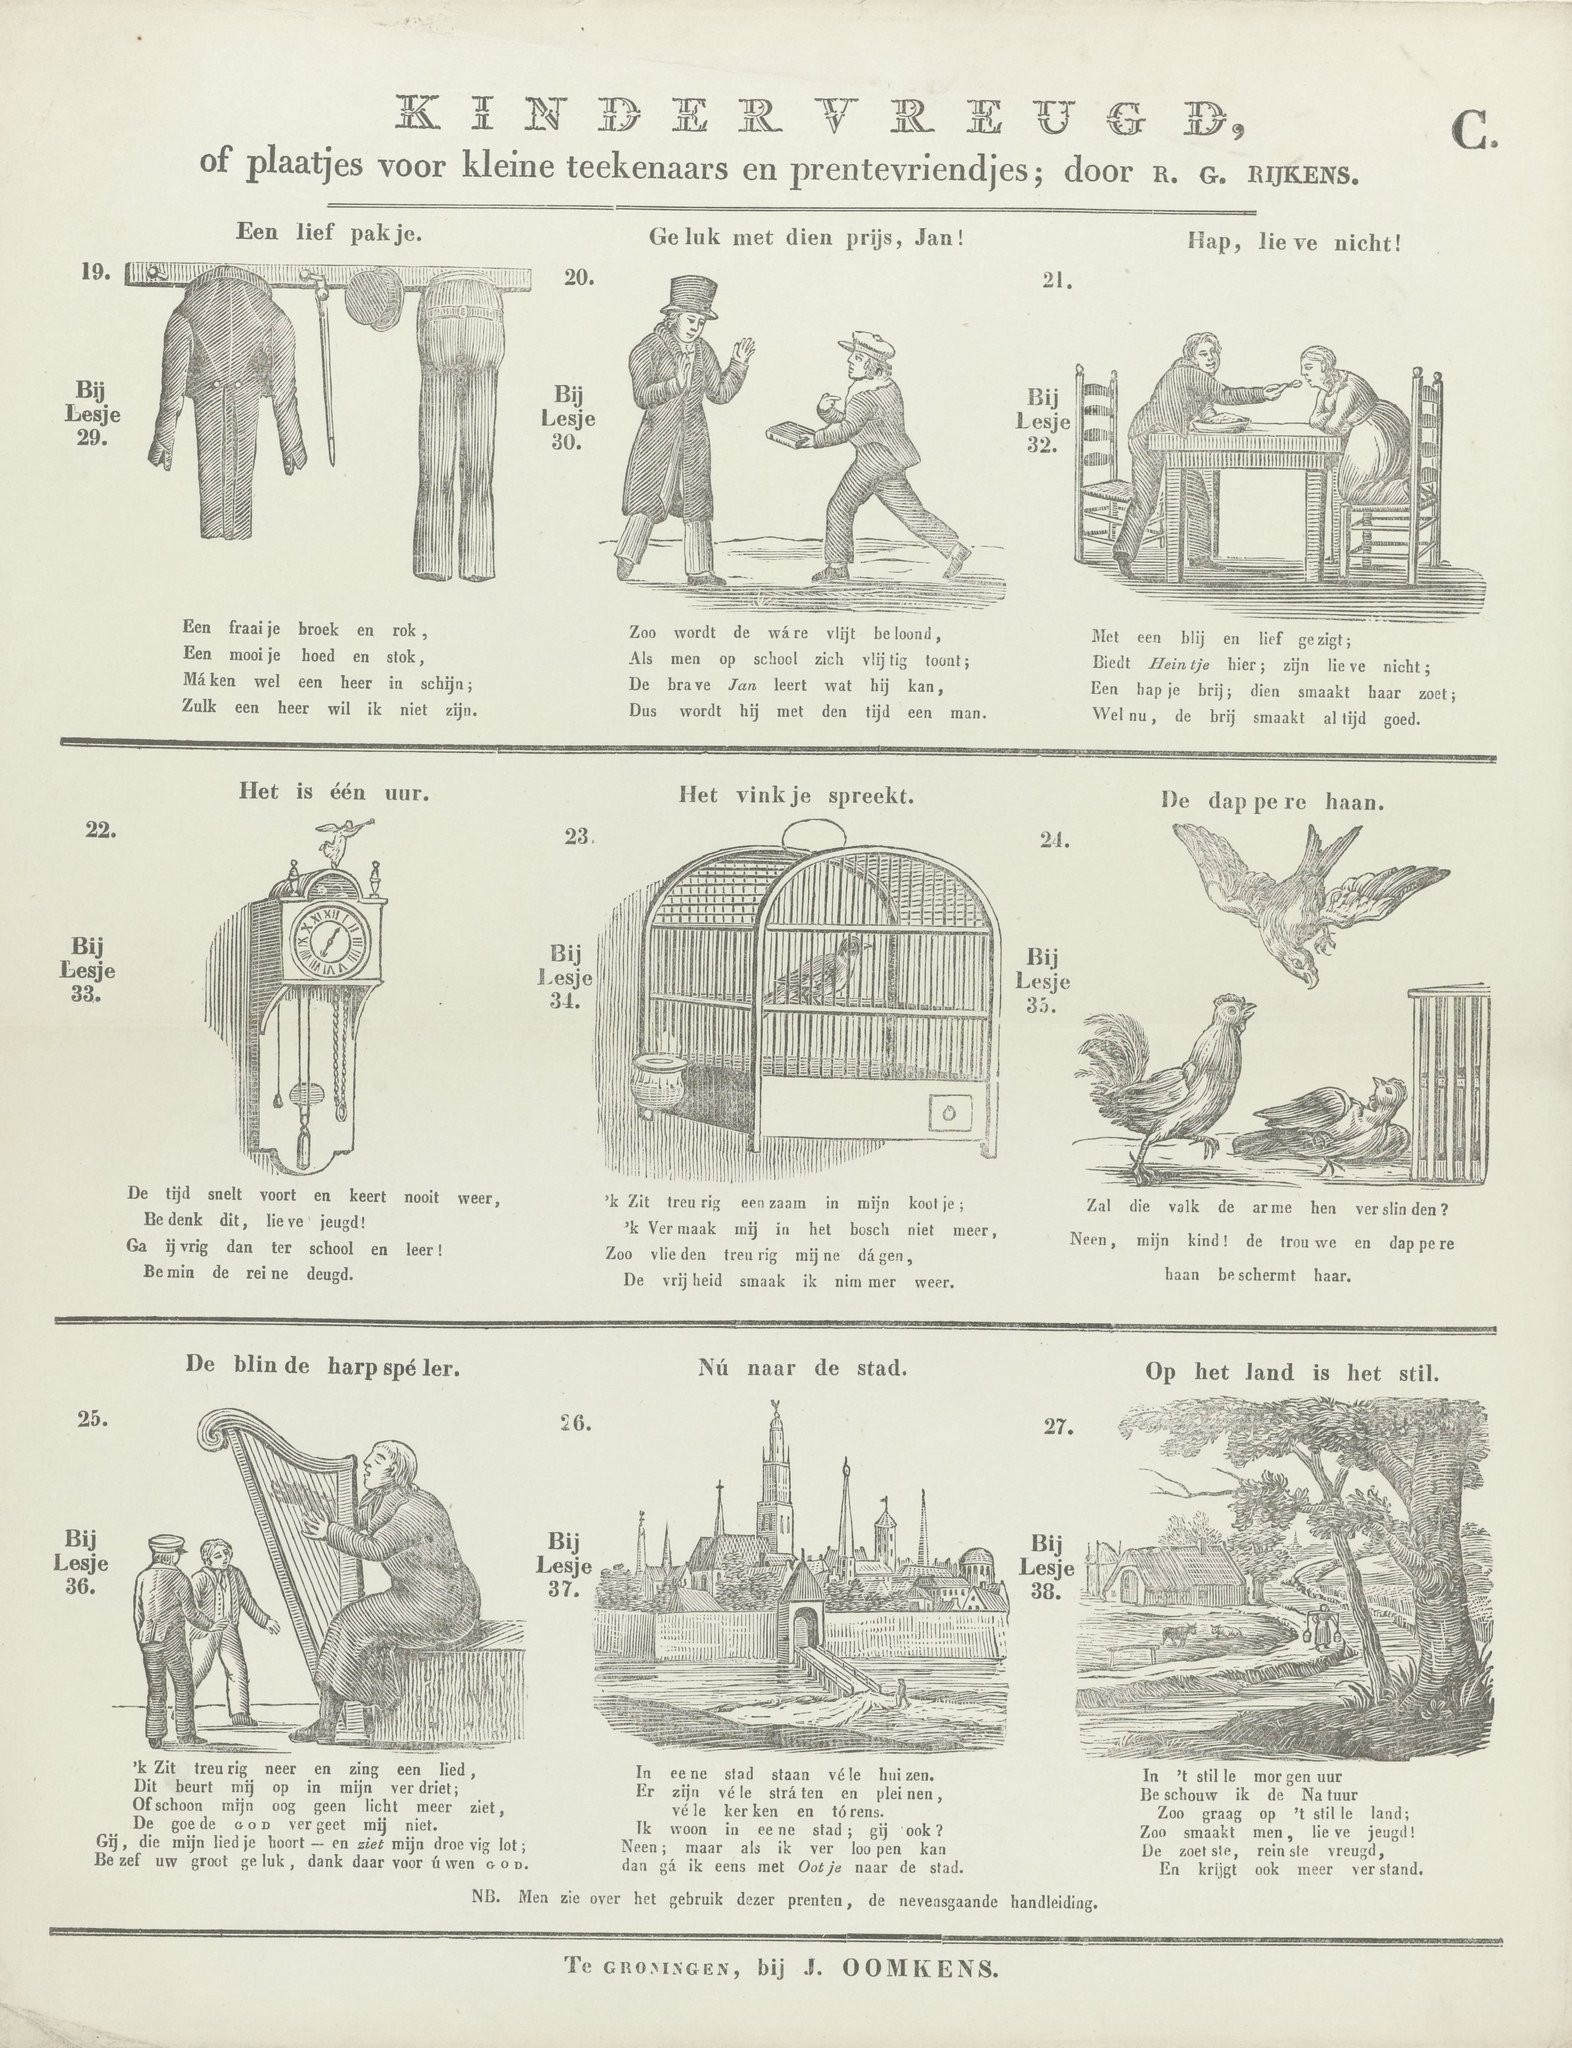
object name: popular print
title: Kindervreugd / of plaatjes voor kleine teekenaars en prentevriendjes; door R. G. Rijkens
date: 1808-1844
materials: paper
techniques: letterpress printing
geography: netherlands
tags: fashion, clothing, harp, clock, fowl (cock, hen, chicken, etc.), education, bird in a cage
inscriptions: collector's mark: Lugt 2760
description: Blad met 9 illustraties (genummerd 19-27) bij leesboekjes van R.G. Rijkens. Elk plaatje hoort bij een lesje uit de boekjes "Natuurlijke Lees-Leerwijze". Weergegeven zijn ondermeer kledingstukken, een klok, een vogelkooi met vogel, een dappere haan en een blinde harpspeler. Boven elke afbeelding een nummer en een titel en onder elke afbeelding een vierregelig vers. Links van elke afbeelding staat vermeld bij welke les het plaatje hoort. Gemerkt rechtsboven: C.